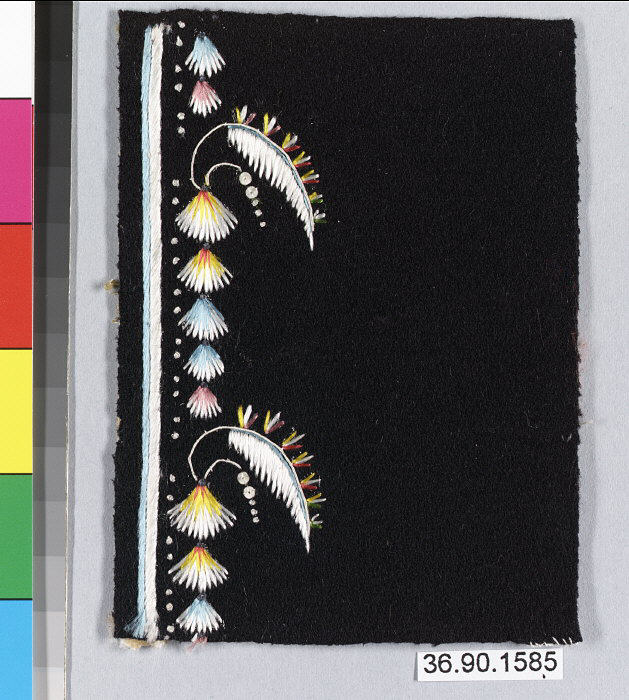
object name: sample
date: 1801-1833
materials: felt, silk